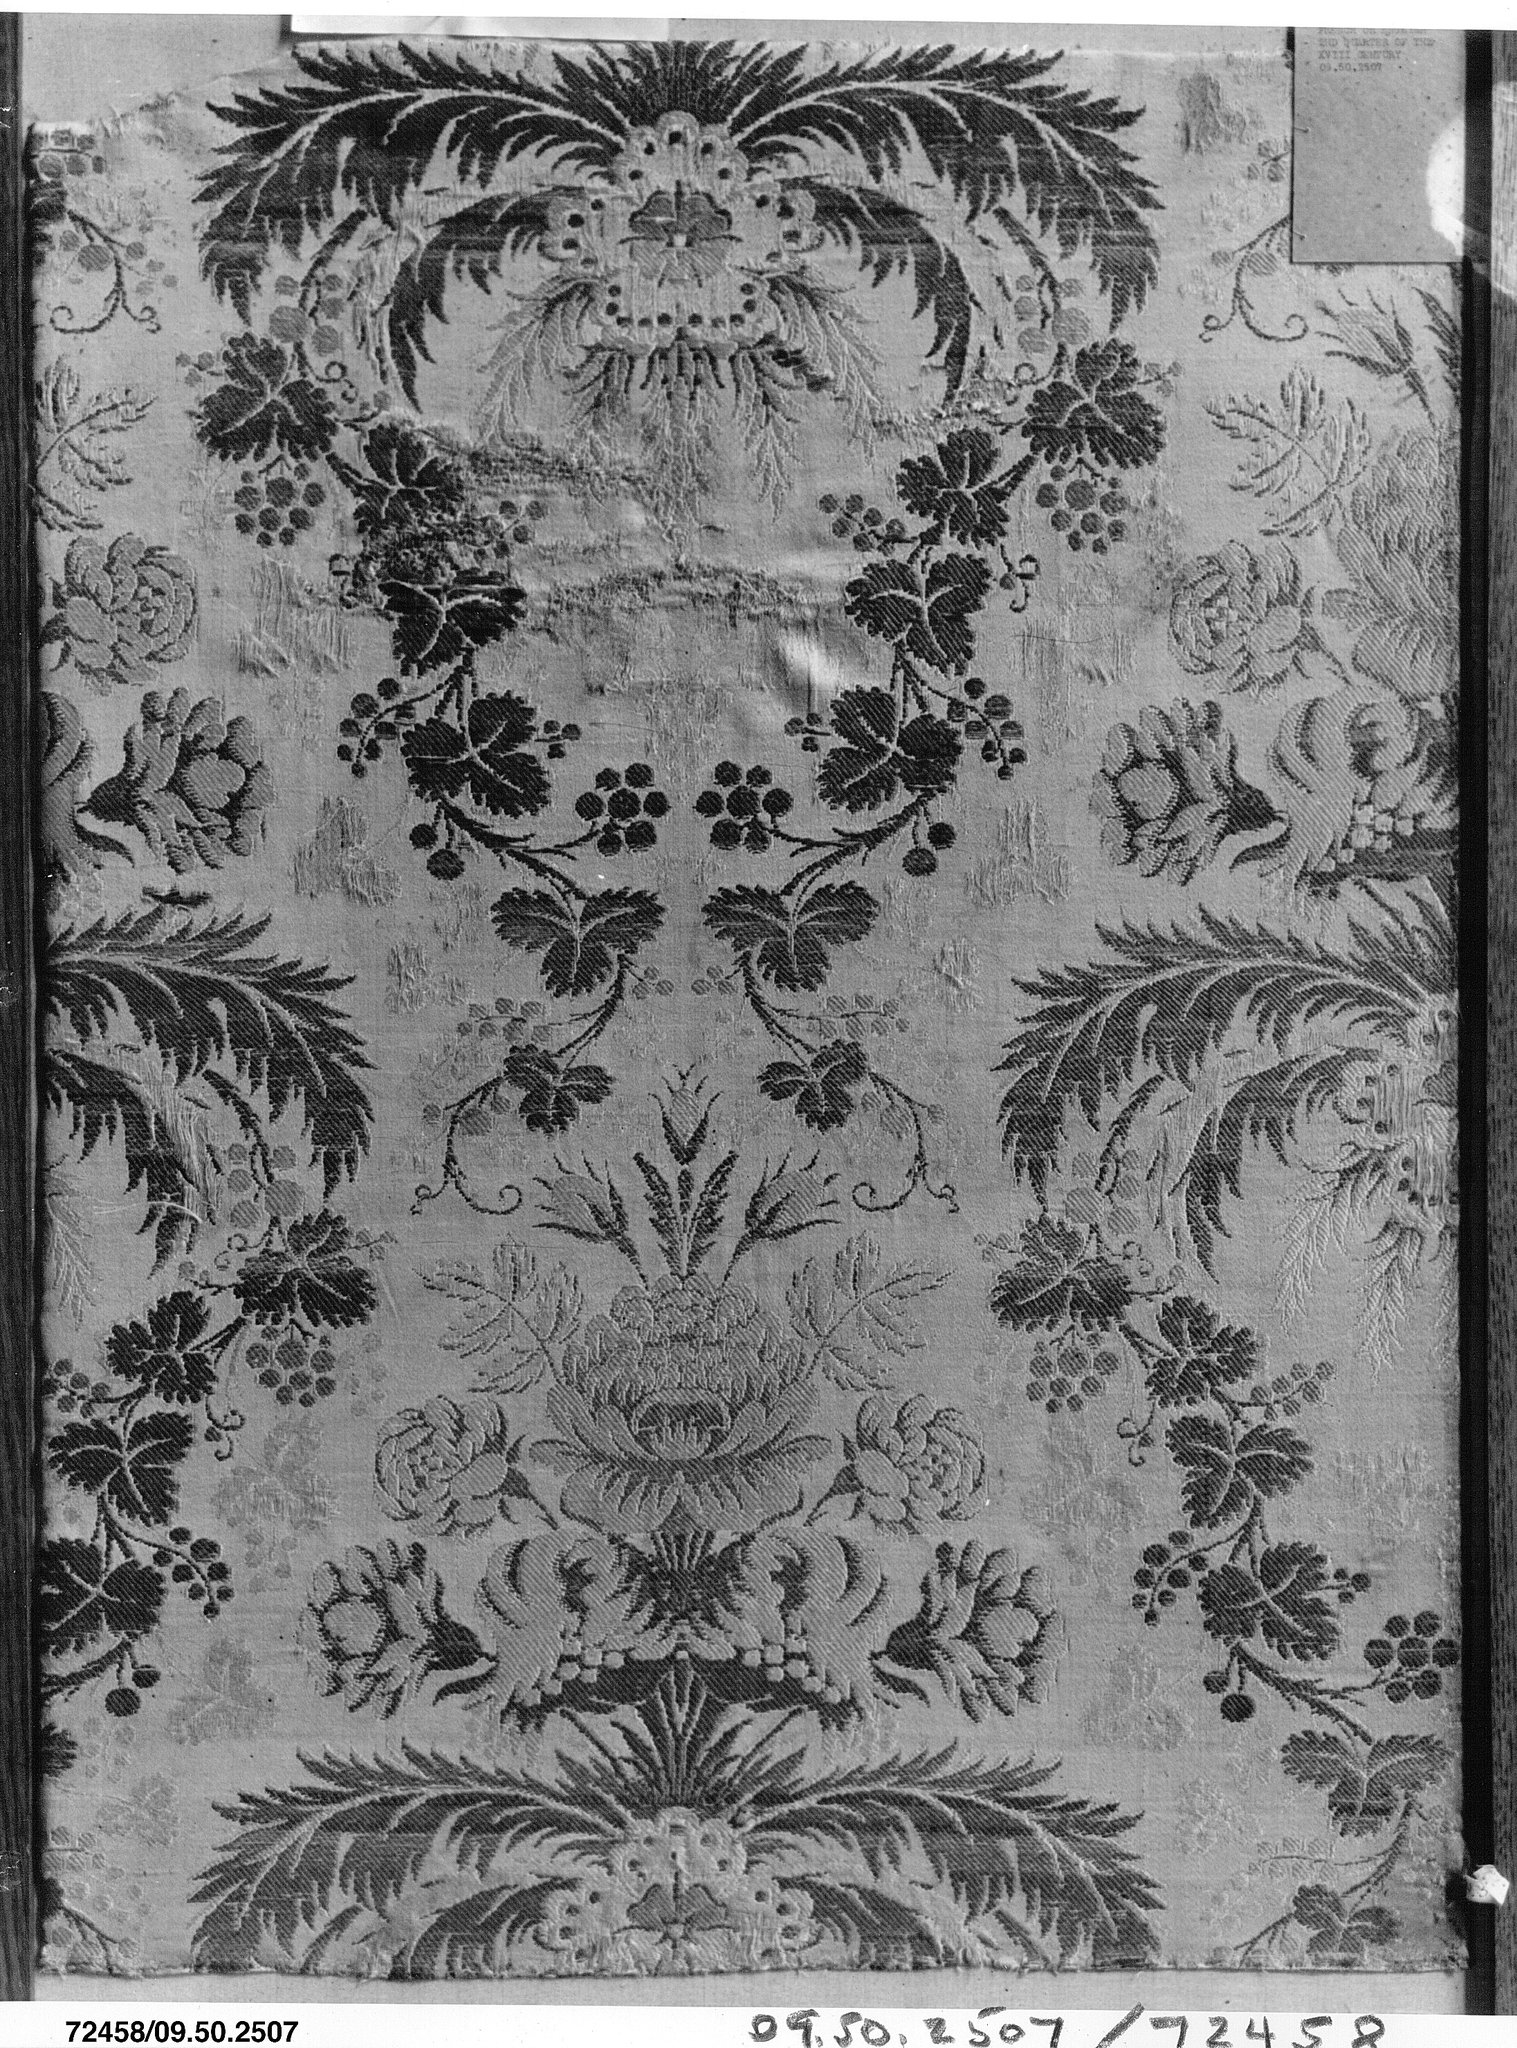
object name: piece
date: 1705-1715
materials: silk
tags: flowers,leaves